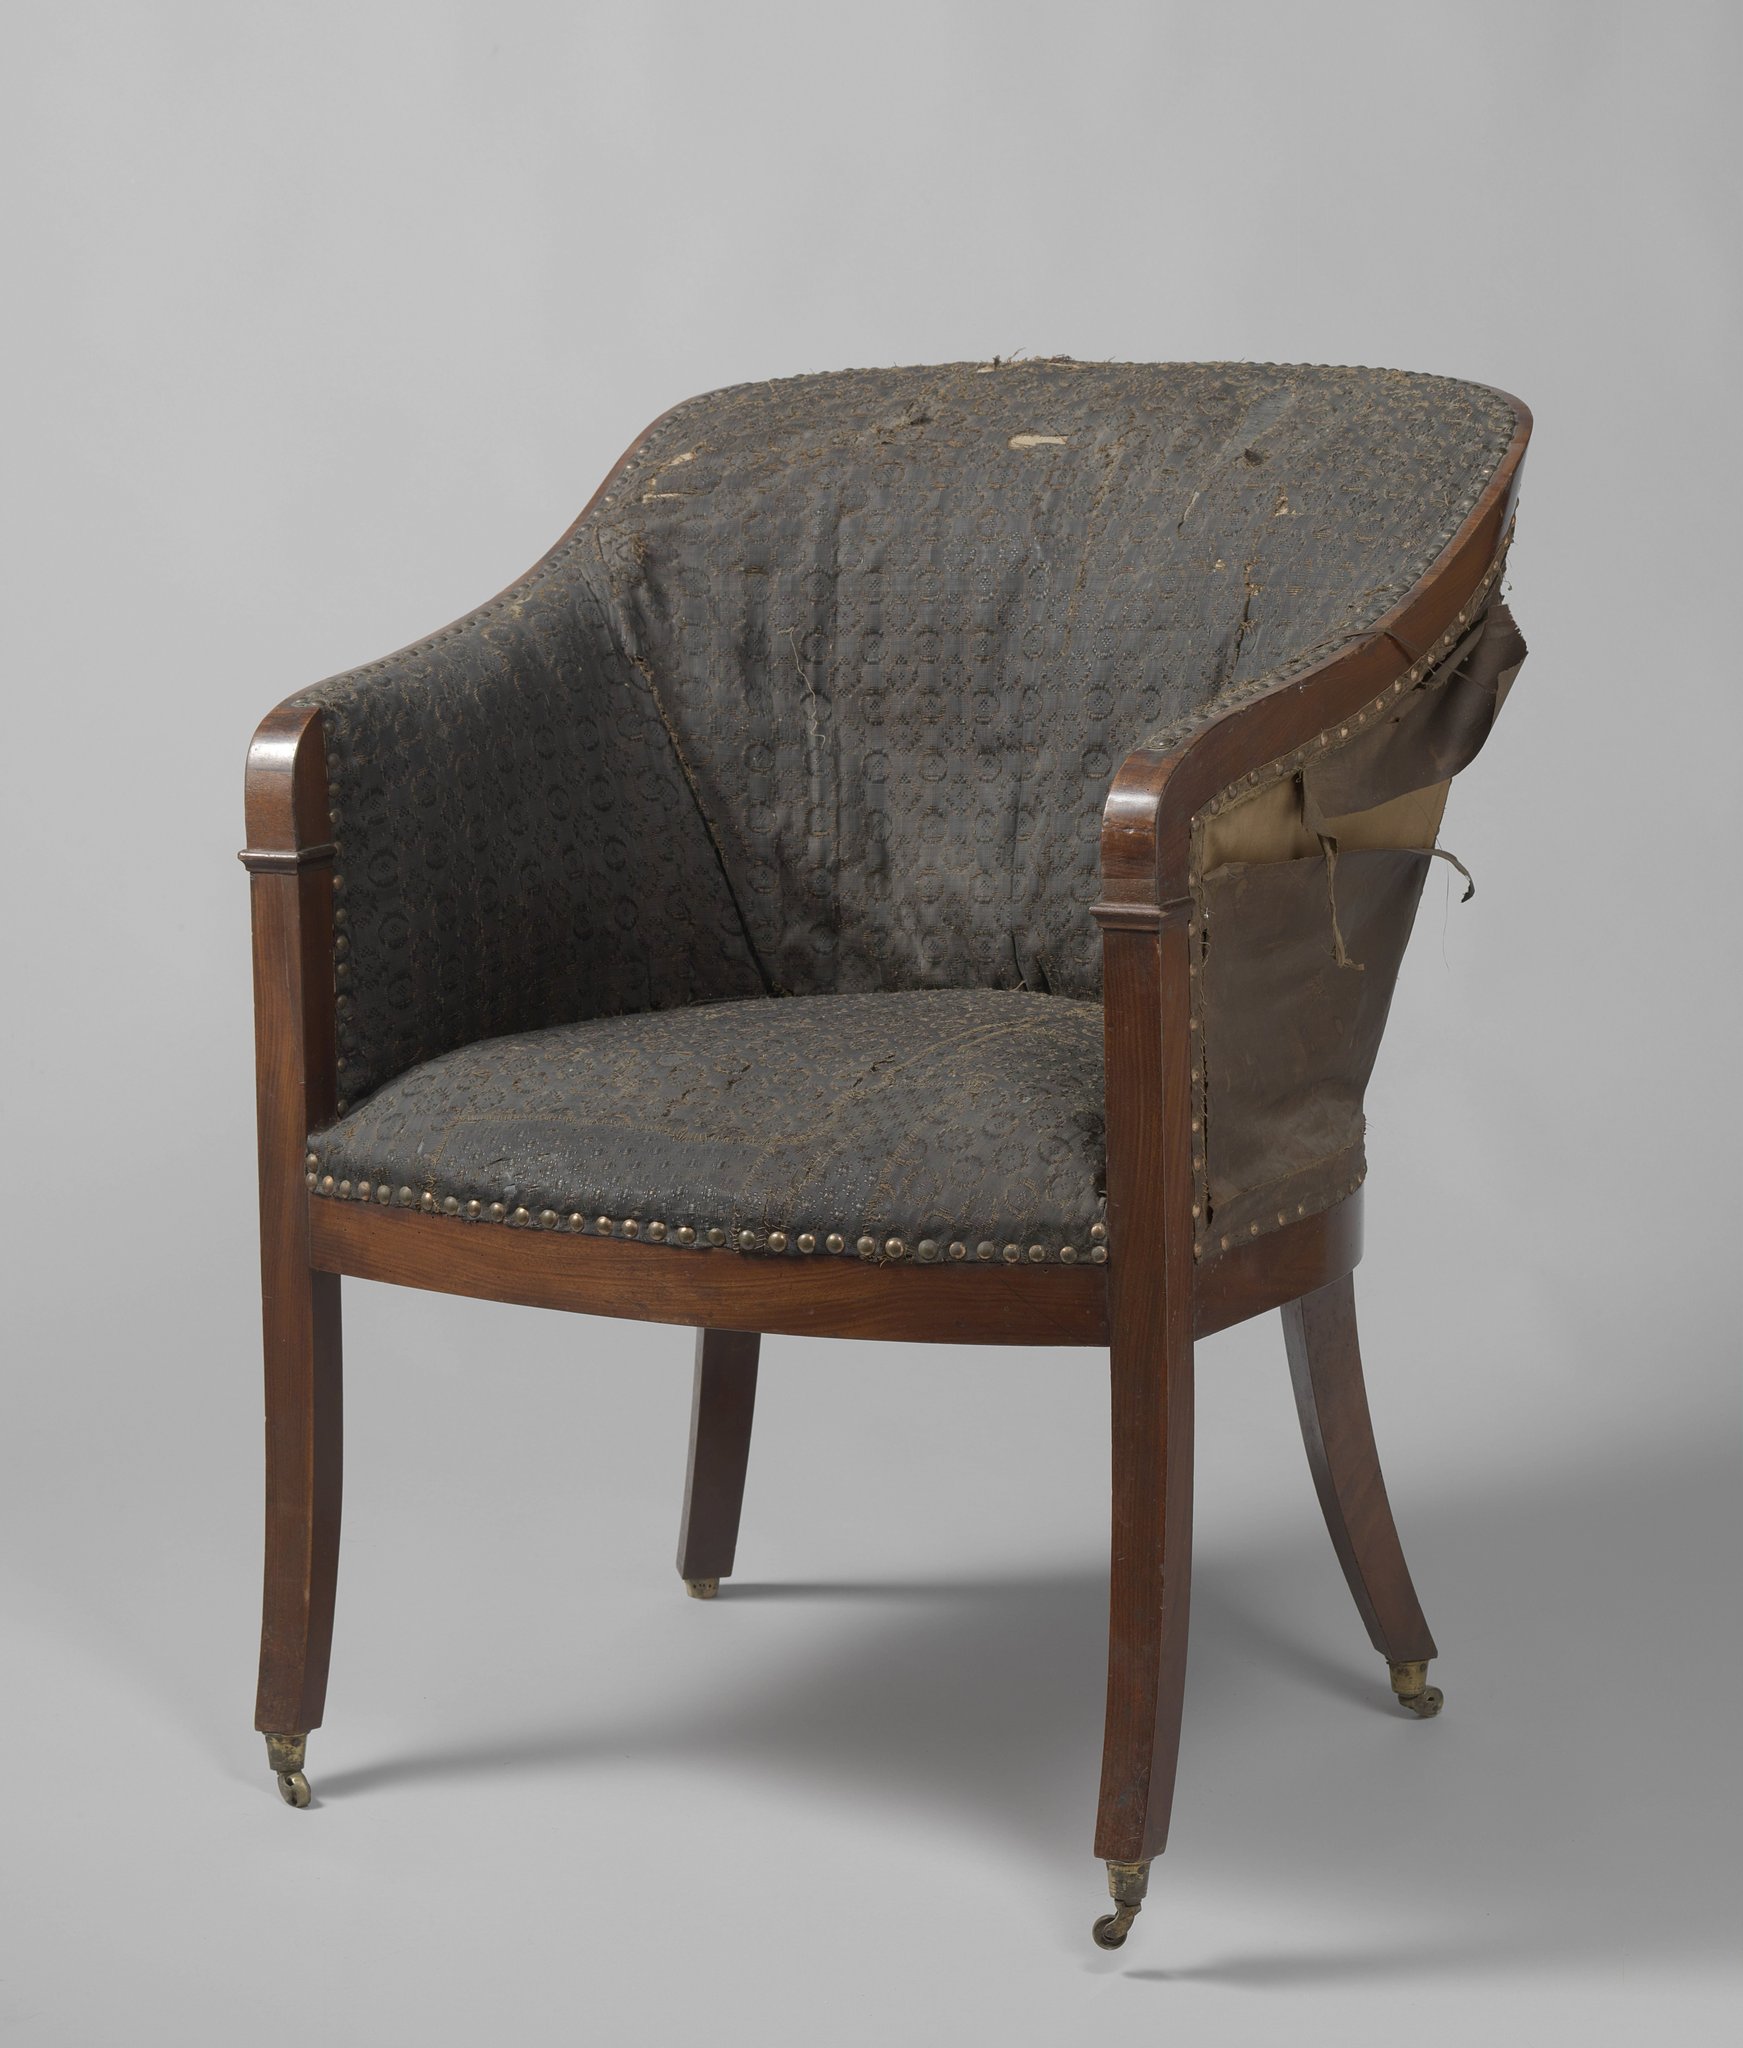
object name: armchair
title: Armstoel, afkomstig van generaal Baron Chassé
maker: Anonymous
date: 1800-1815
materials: hair, wood, metal, textile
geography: low countries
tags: david hendrik baron chassé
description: Armstoel van mahoniehout bekleed met stof dat een patroon van kransen en ruiten vertoont. De poten zijn sabelvormig en zijn aan de bovenkant, voordat zij overgaan in de leuning, geprofileerd. De rug is met de armleggers in een achterover hellende beweging verbonden (het z.g. Gondole-model) en rondom bekleed. De bekleding is met nagels afgezet. De poten rusten op, later aangebrachte, wielen. Afkomstig van generaal Baron Chassé.